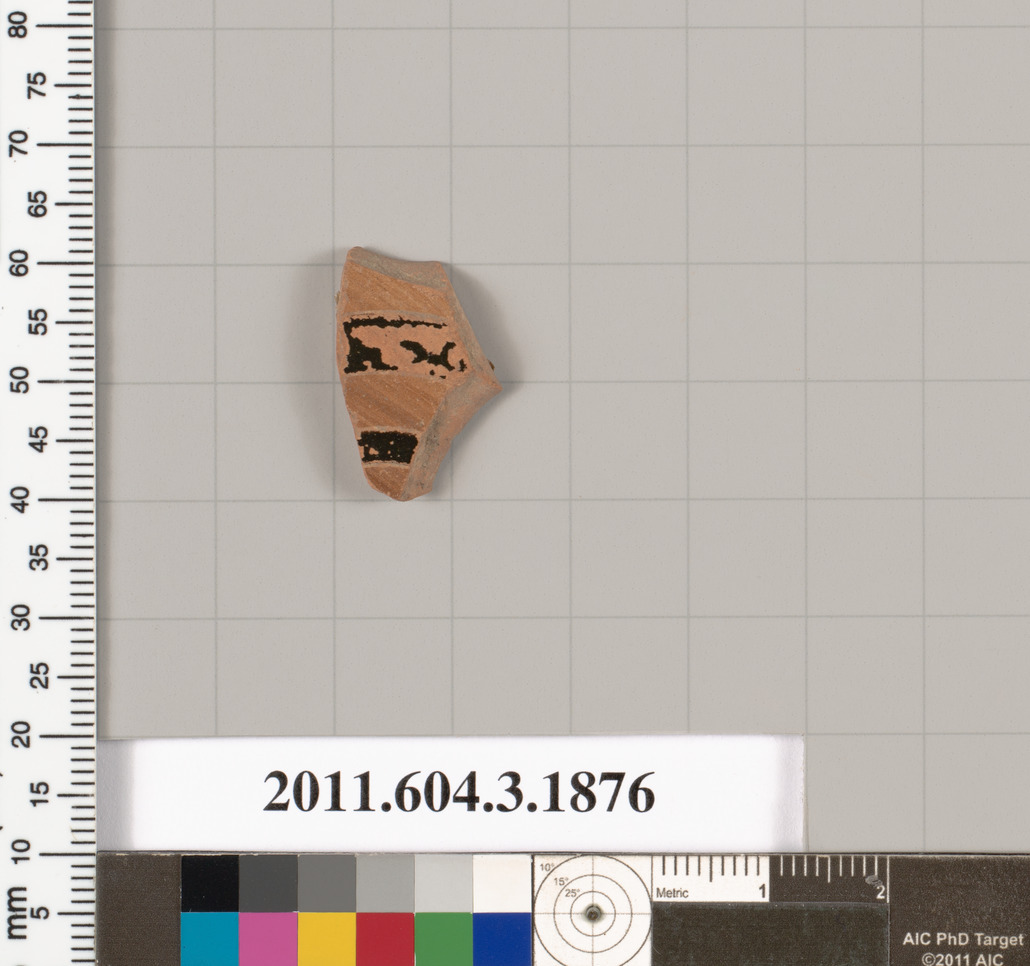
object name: kylix fragment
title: Terracotta fragment of a kylix: Band or lip cup (drinking cup)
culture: greek, attic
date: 520-510 BCE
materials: terracotta